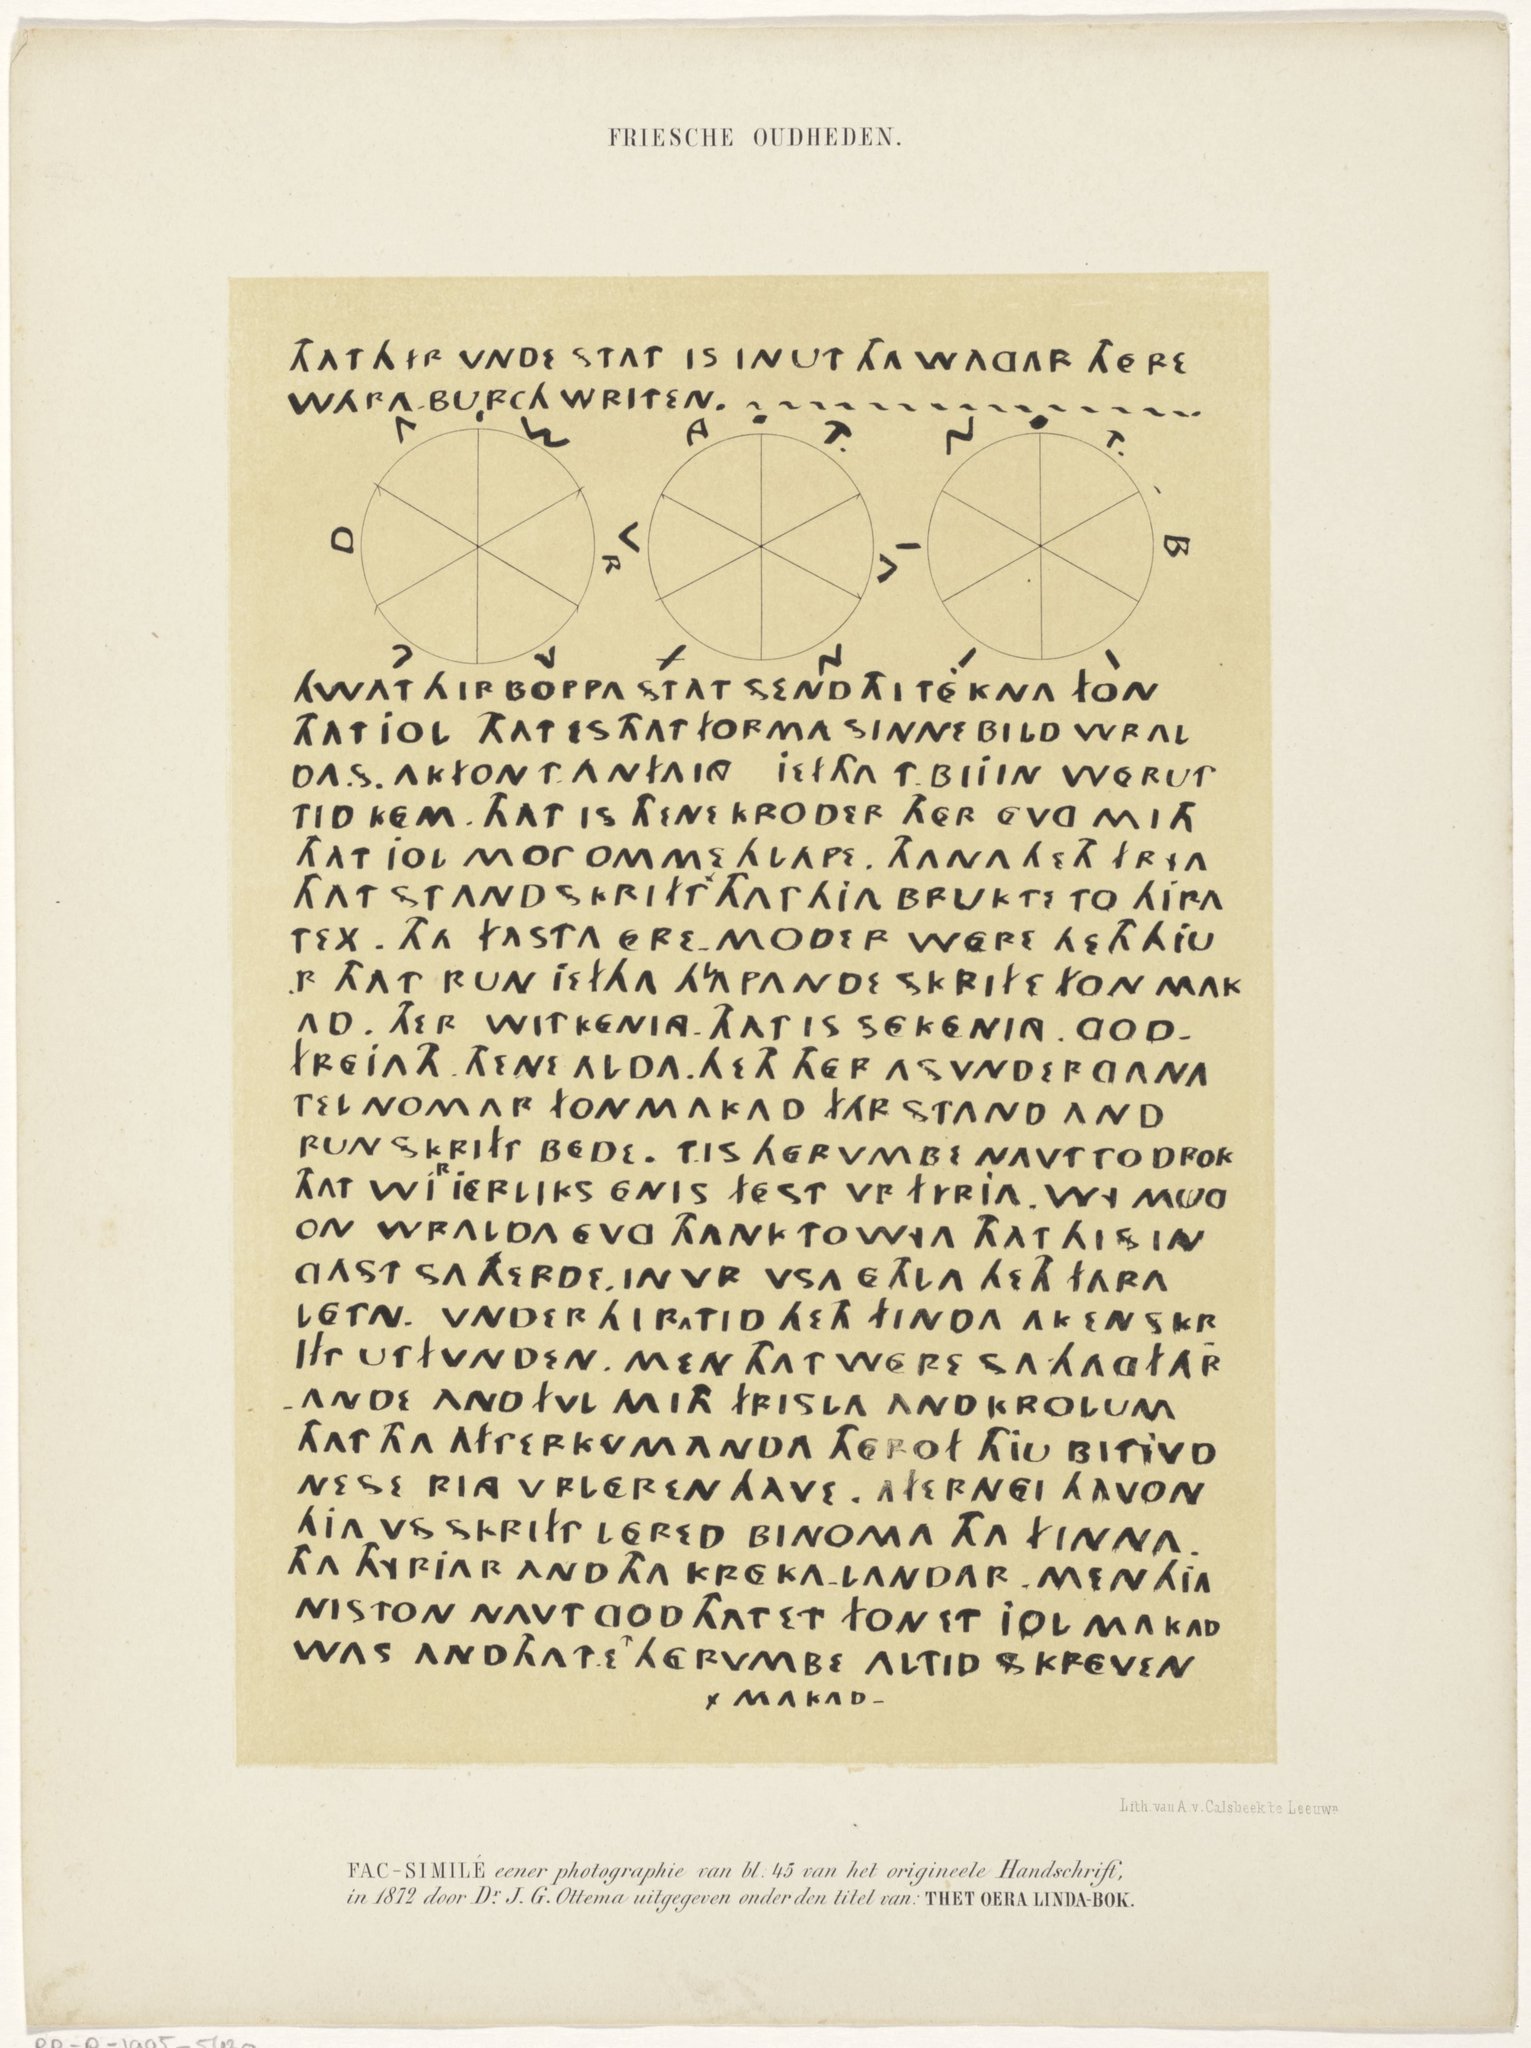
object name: book illustration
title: Bladzijde uit het Oera Linda-Bok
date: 1875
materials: paper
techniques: tone lithography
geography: netherlands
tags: letters, alphabet, script (+ divulgation of the results of research), excavation ~ archaeology (+ counterfeit, fake, forgery ~ sciences)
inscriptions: collector's mark: Lugt 2228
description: Prent uit: S.n. Friesche oudheden. Afbeeldingen van merkwaardige voorwerpen van wetenschap en kunst gevonden in de archieven, kerken, kasteelen, terpen enz. van Friesland. Leeuwarden: Kuipers, H., 1875.